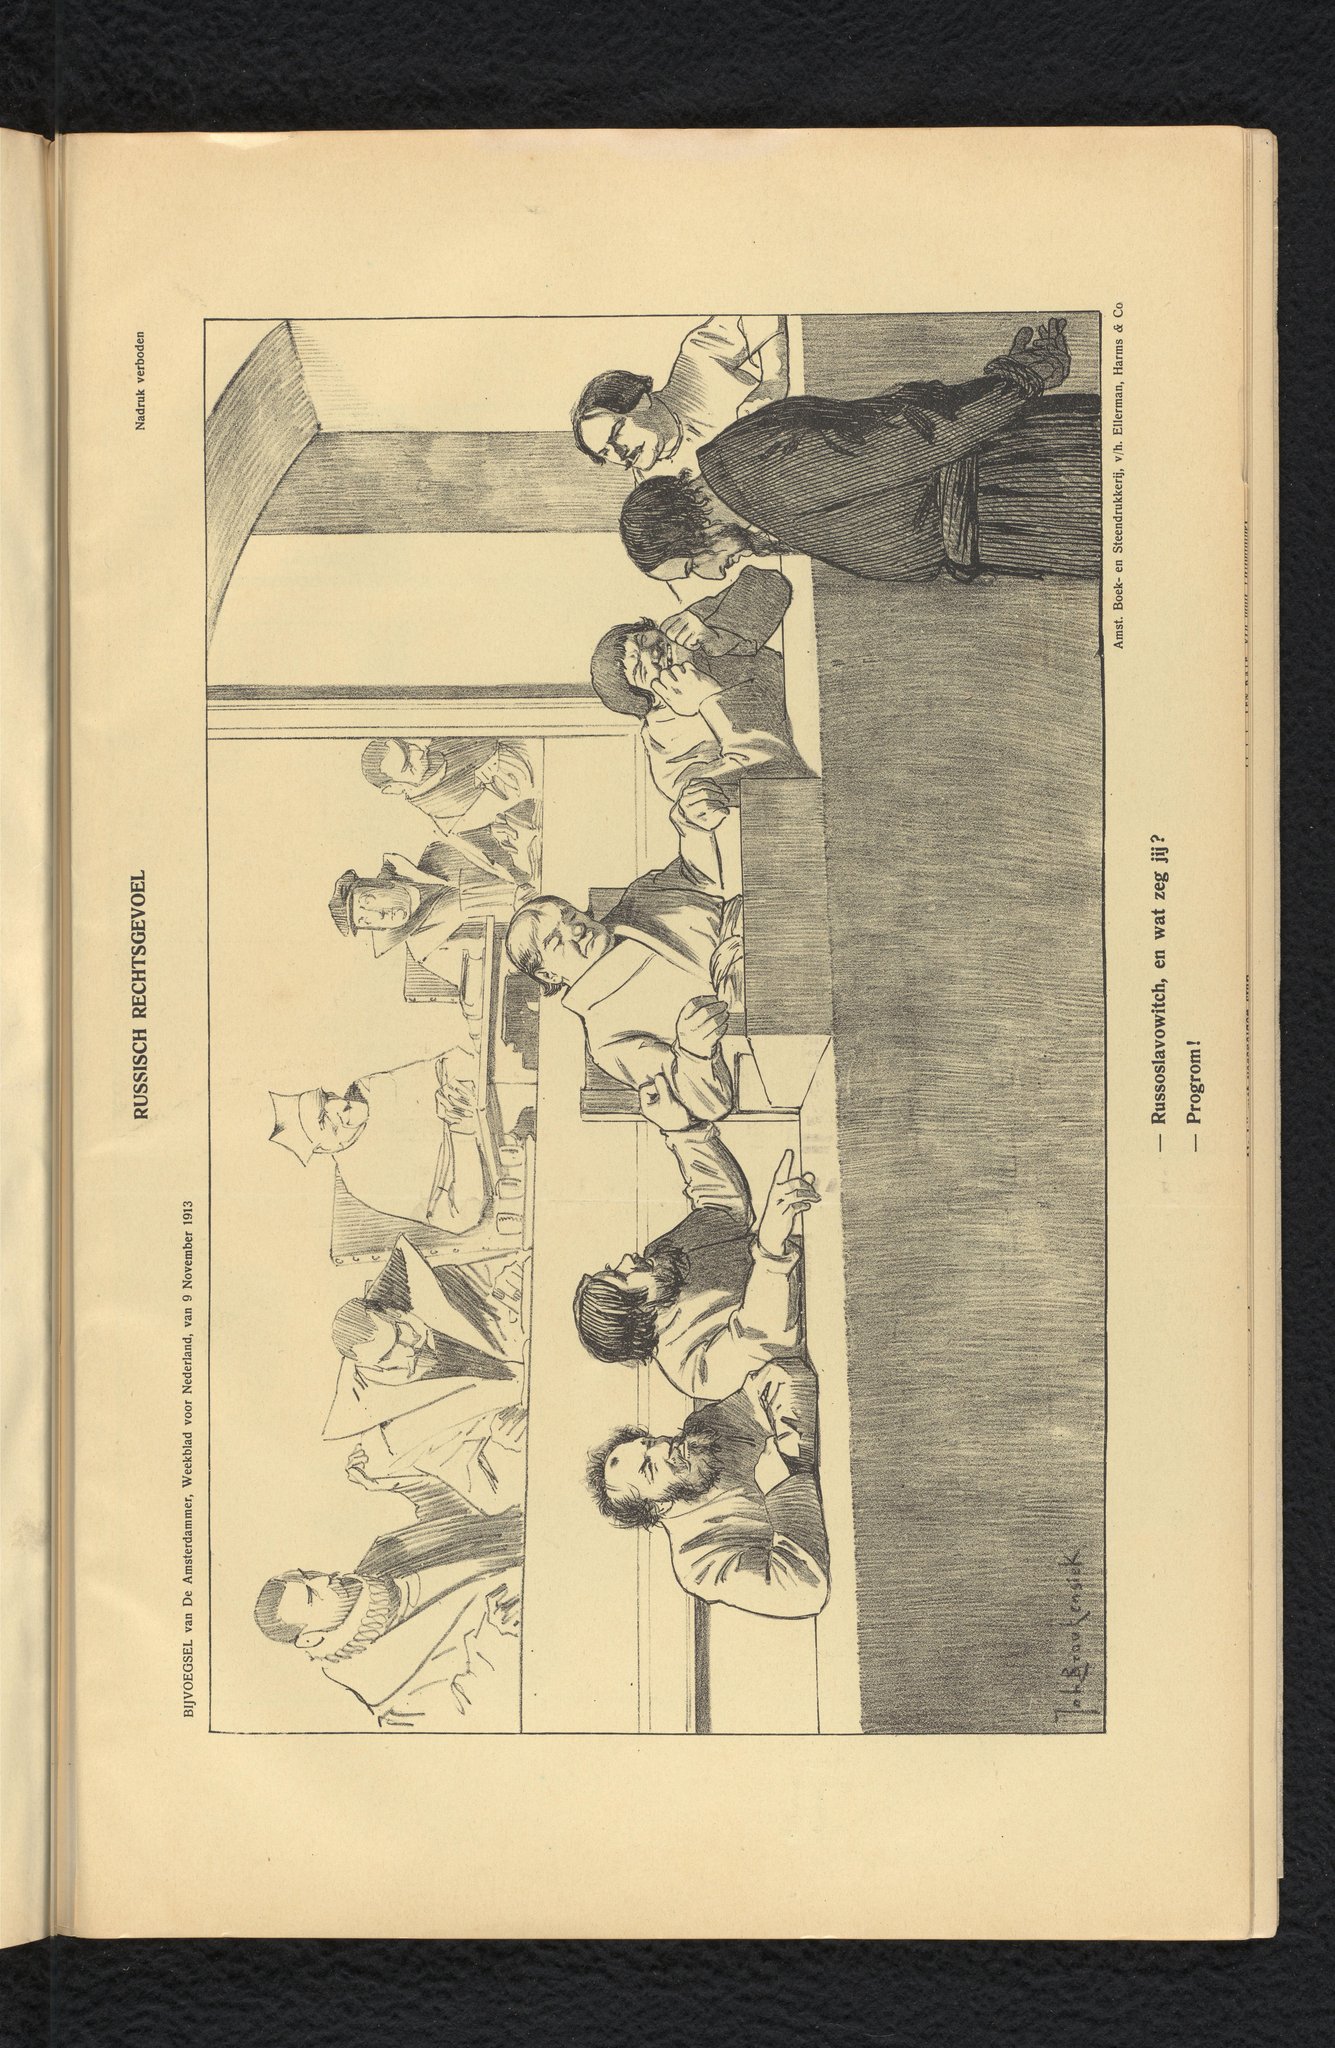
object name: cartoon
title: Russisch rechtsgevoel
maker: johan braakensiek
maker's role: draughtsman, print maker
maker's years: 1858-1940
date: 1913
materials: paper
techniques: lithograph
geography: netherlands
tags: outbreaks of violence ~ anti-semitism, judicial verdict, massacre, 'pogrom' ~ anti-semitism, political caricatures and satires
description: Een Russische Jood voor een Russisch rechtbank gebracht en veroordeeld tot 'progrom', oftewel Jodenmoord. Achter de rechters een schim van een beruchte voorganger, mogelijk Alva's Raad van Beroerten (de 'Bloedraad'), of de Spaanse Inquisitie.